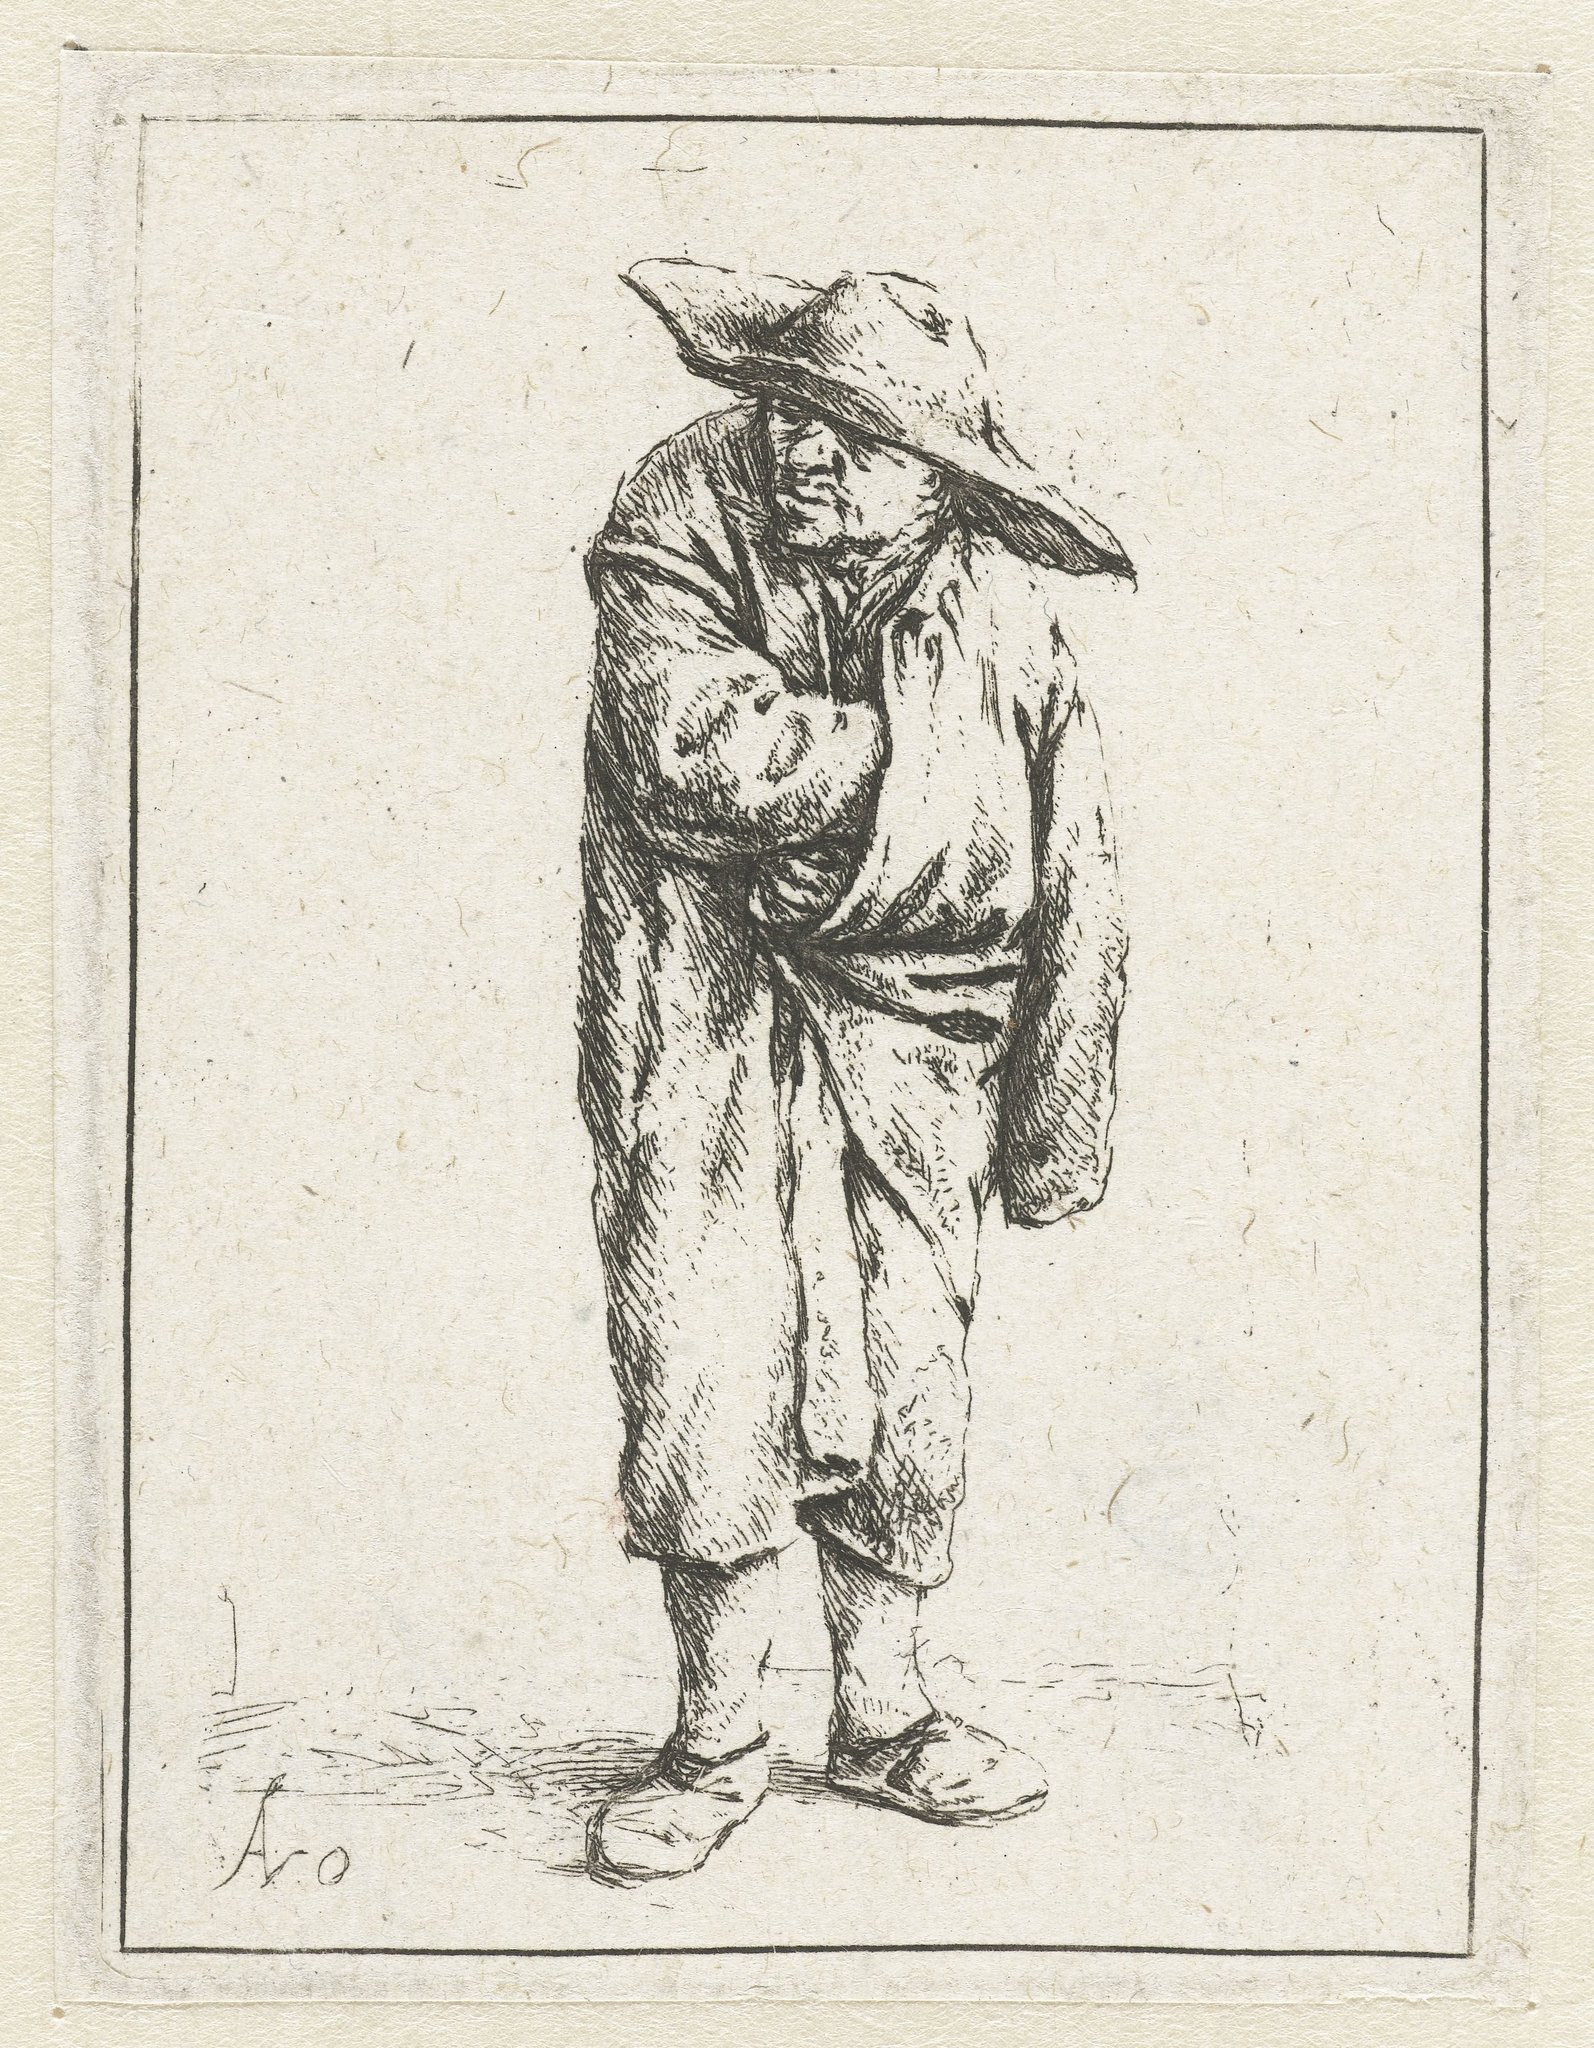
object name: print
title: Staande boer met hand en arm in zijn mantel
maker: adriaen van ostade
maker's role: draughtsman, painter, print maker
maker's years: 1610-1685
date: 1646-1648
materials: paper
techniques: etching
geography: haarlem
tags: coat (+ men's clothes), male sex; man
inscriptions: collector's mark: Lugt 2228a, collector's mark: Lugt 2610